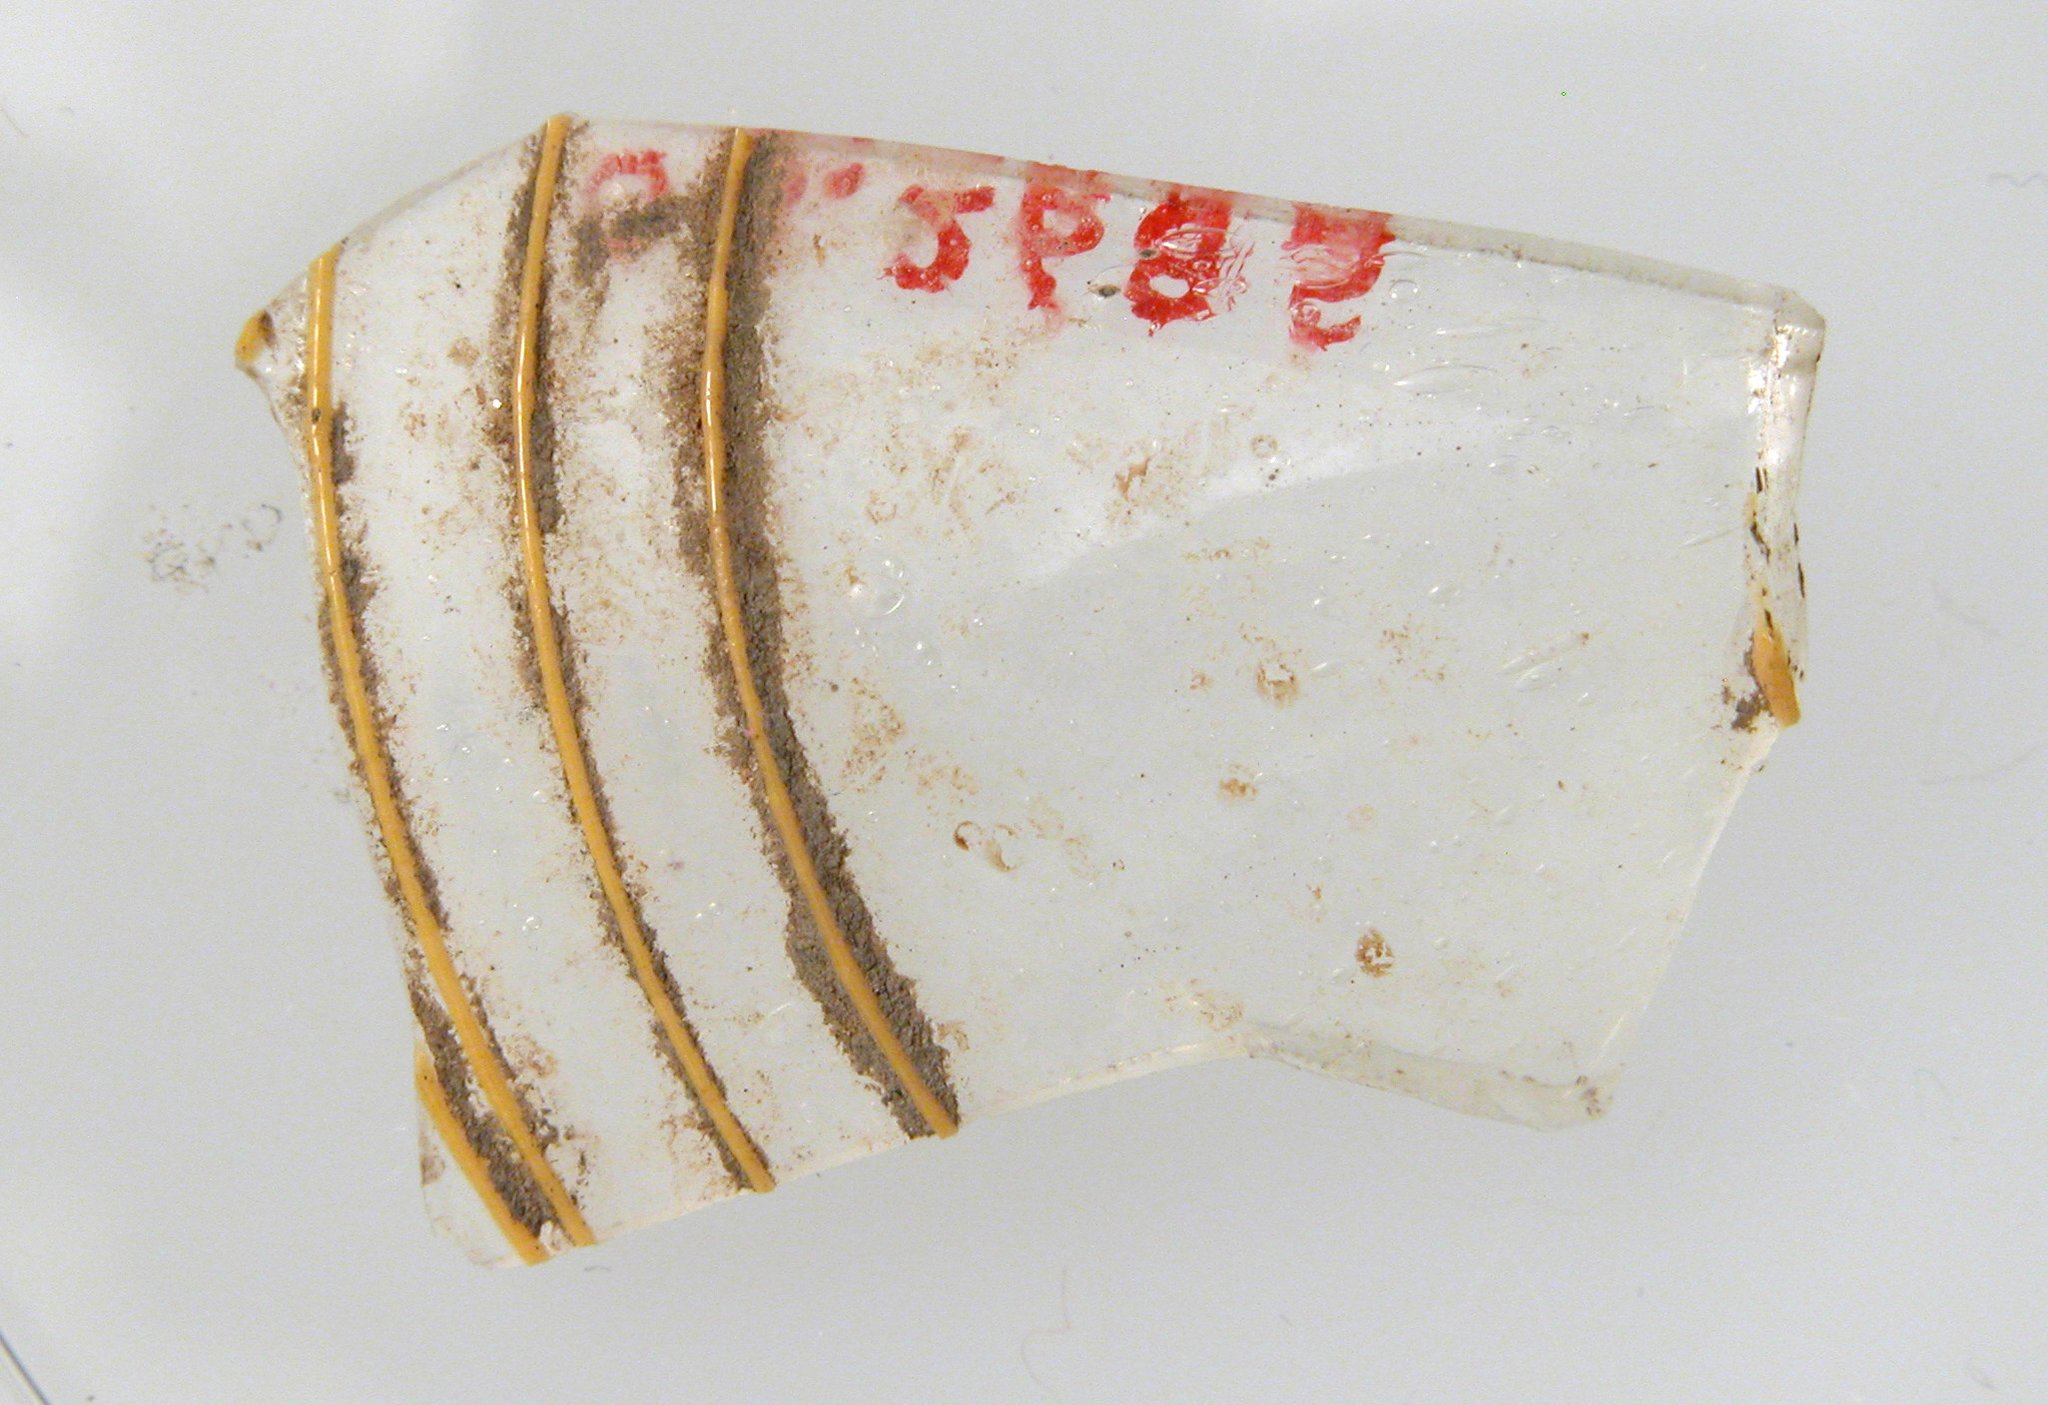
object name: fragment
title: Glass Fragment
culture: coptic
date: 301-433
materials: glass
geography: egypt